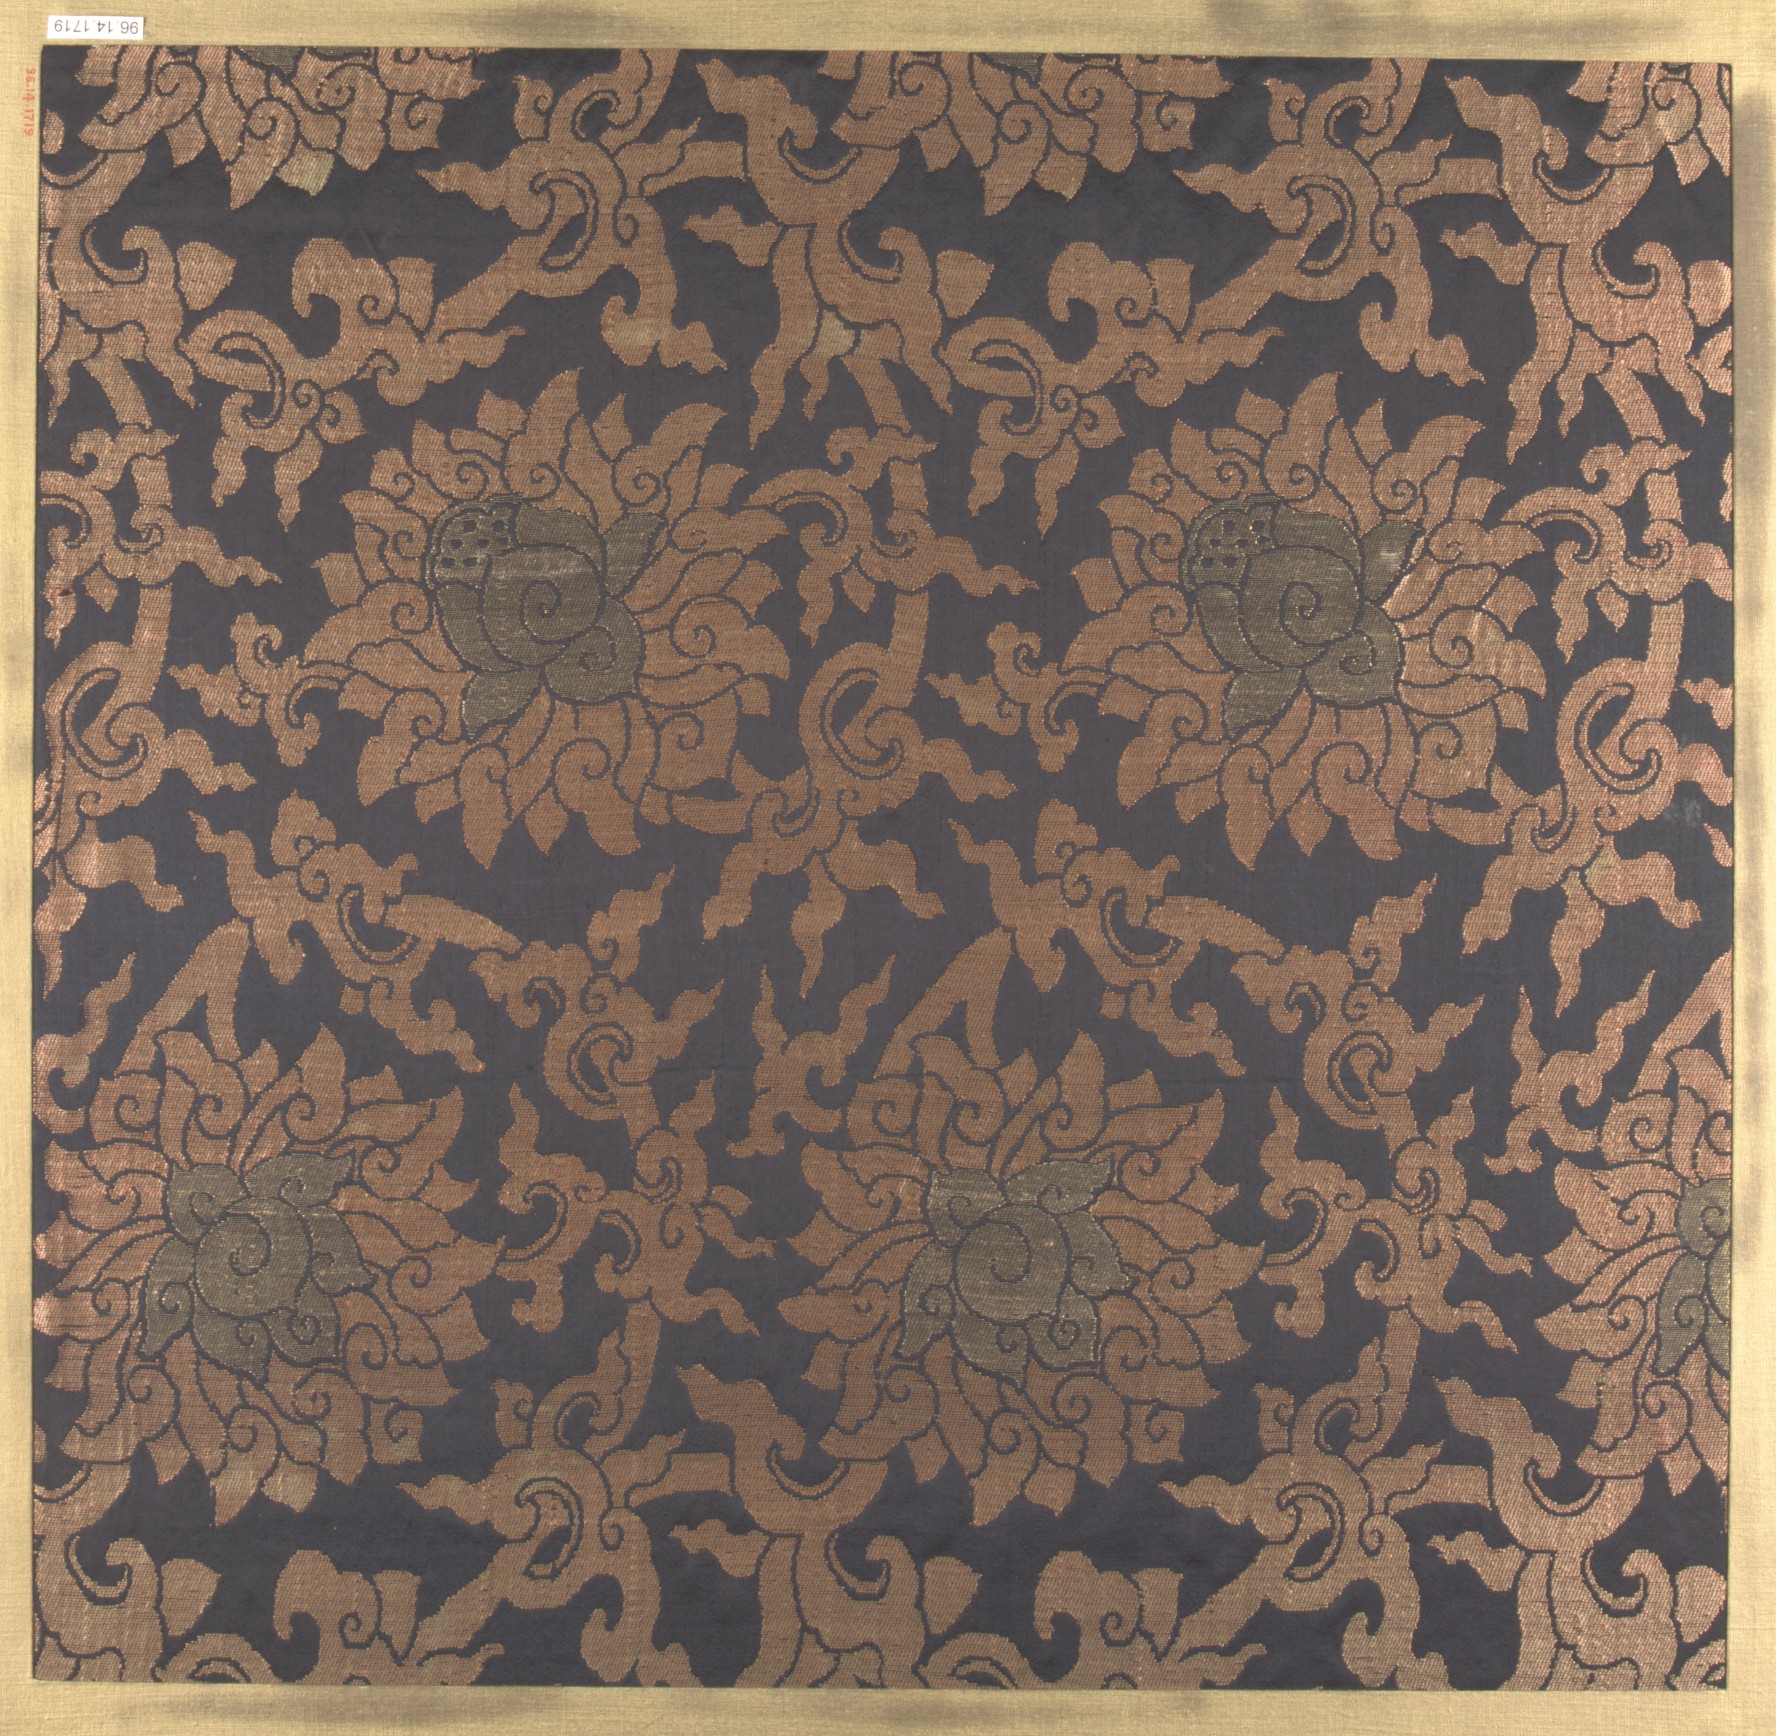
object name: piece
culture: japanese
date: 1701-1900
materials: silk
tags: flowers